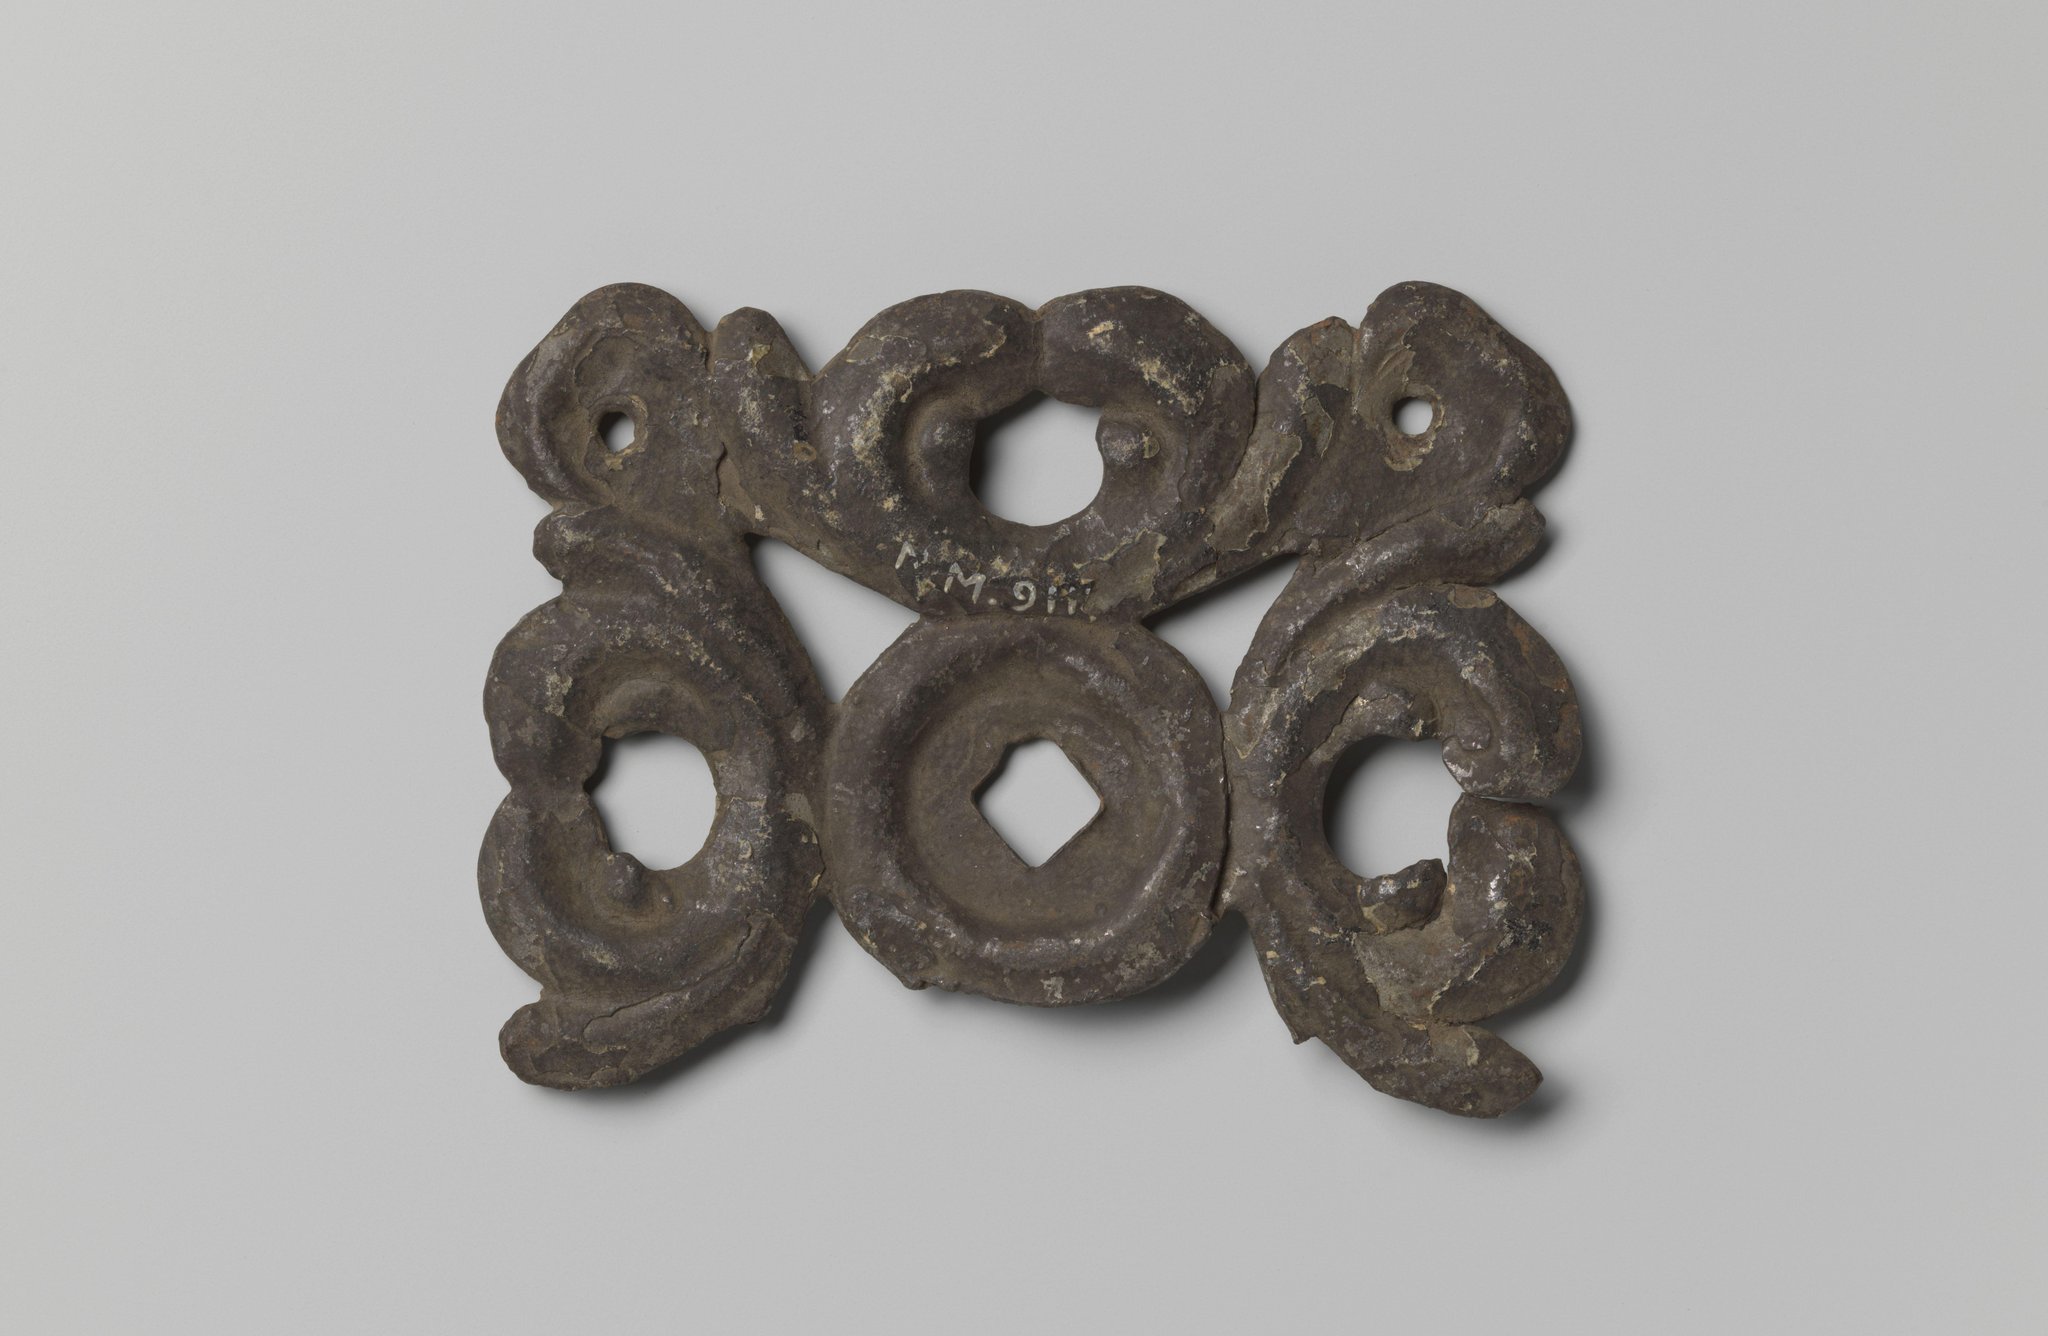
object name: fragment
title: Beslag van een deurtrekker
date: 1400-1950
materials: iron